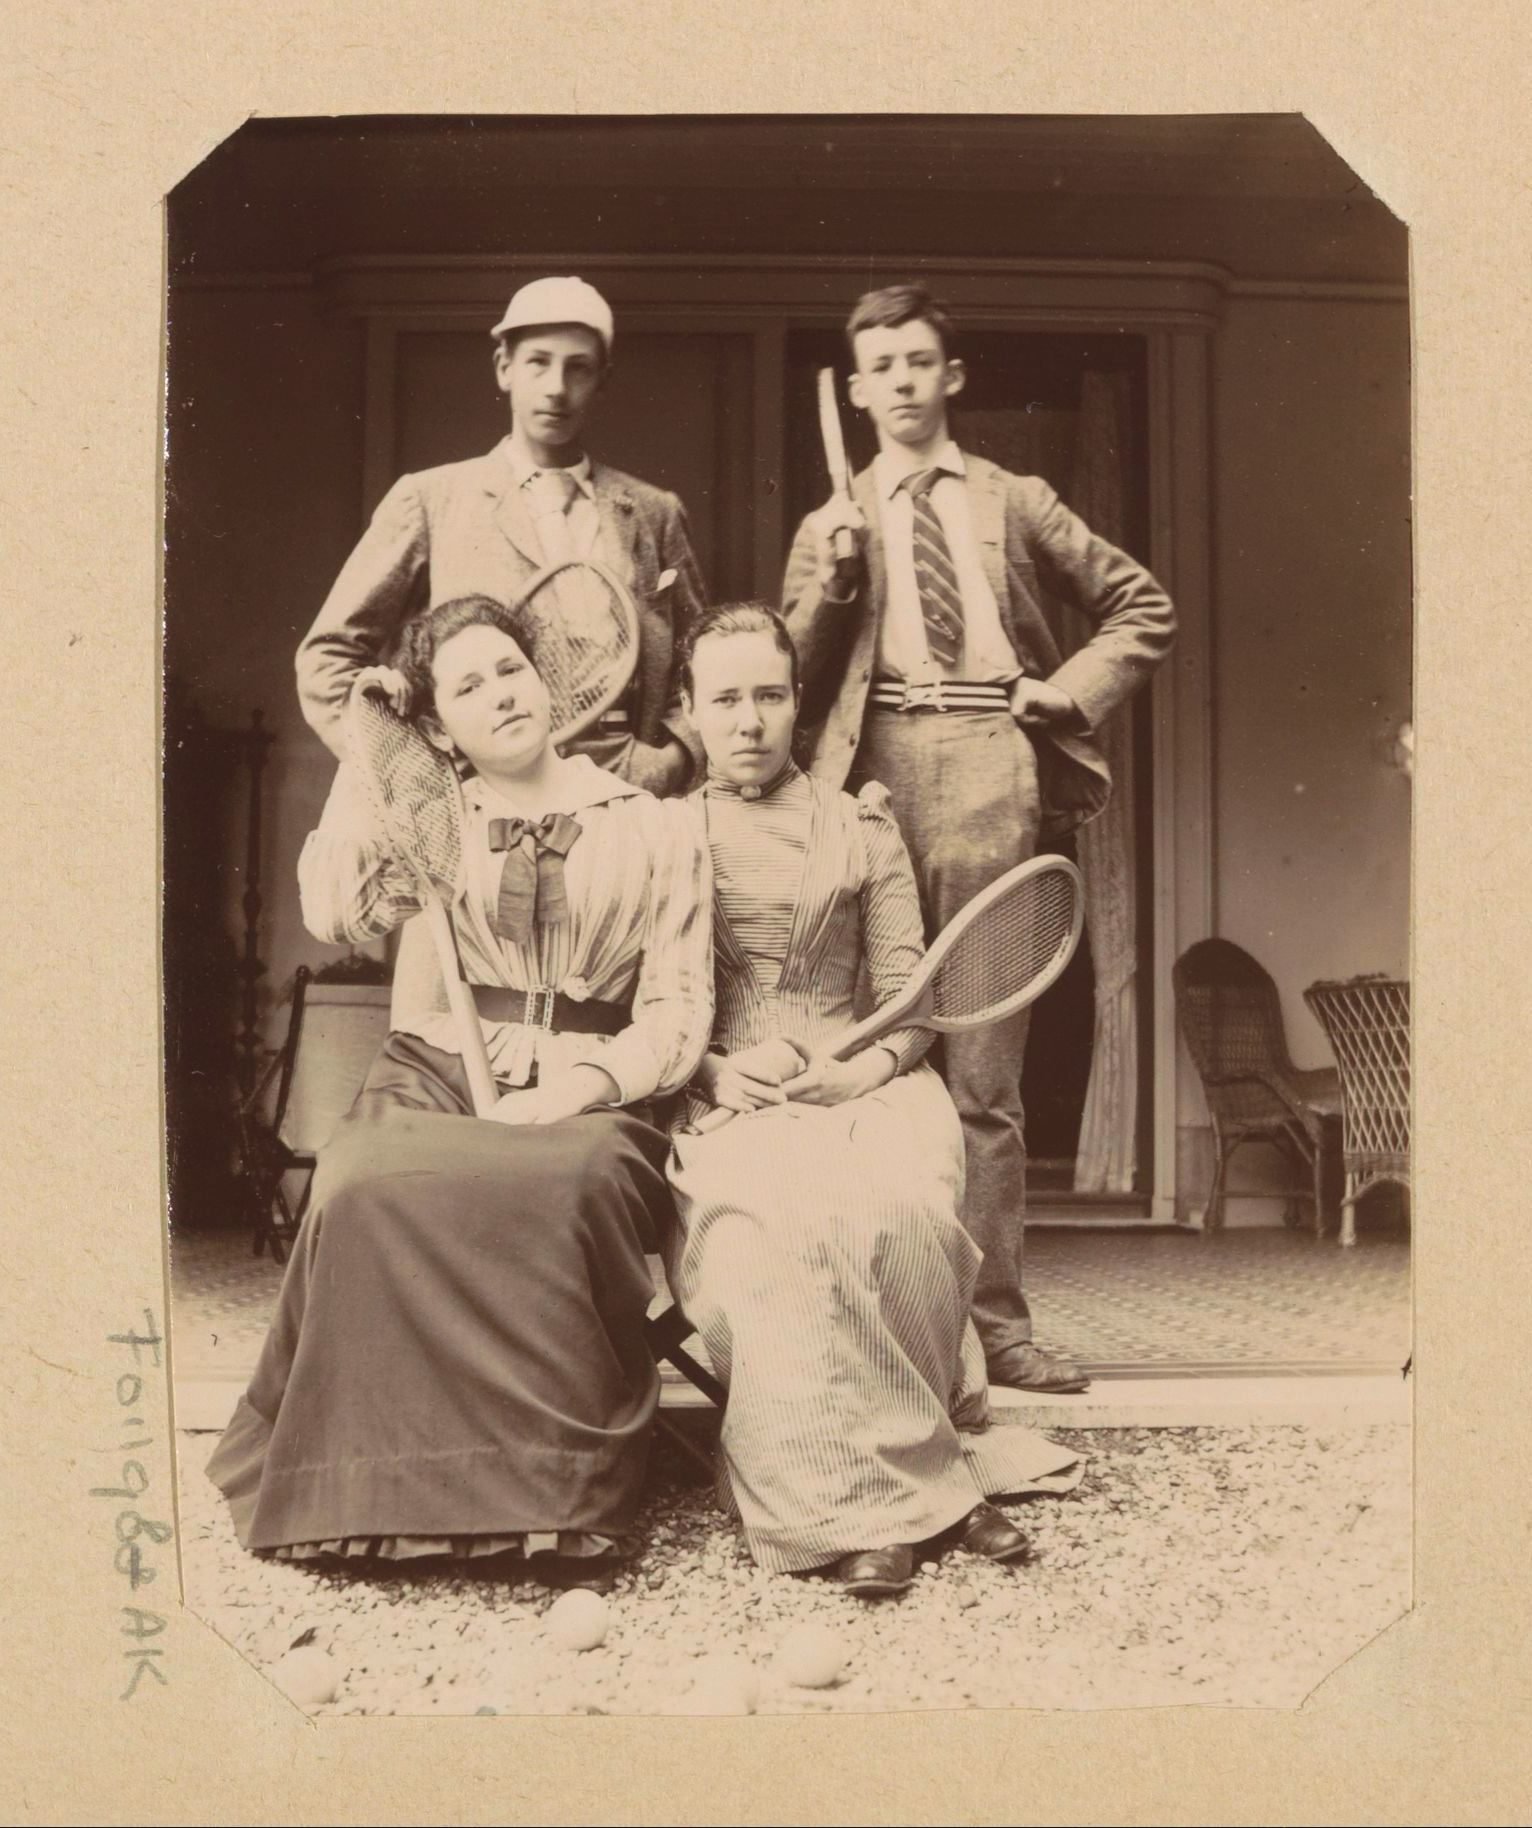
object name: album leaf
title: Groepsportret met tennisrackets, staand aan de rechterzijde Willem Frederik Piek Jr.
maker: johanna margaretha piek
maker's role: fotograaf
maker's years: 1870-1947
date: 1889-1893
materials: paper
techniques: gelatin silver print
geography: netherlands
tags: amsterdam, willem frederik piek jr., tennis, lawn-tennis, family life, anonymous historical persons portrayed in a group, in a group-portrait, netherlands